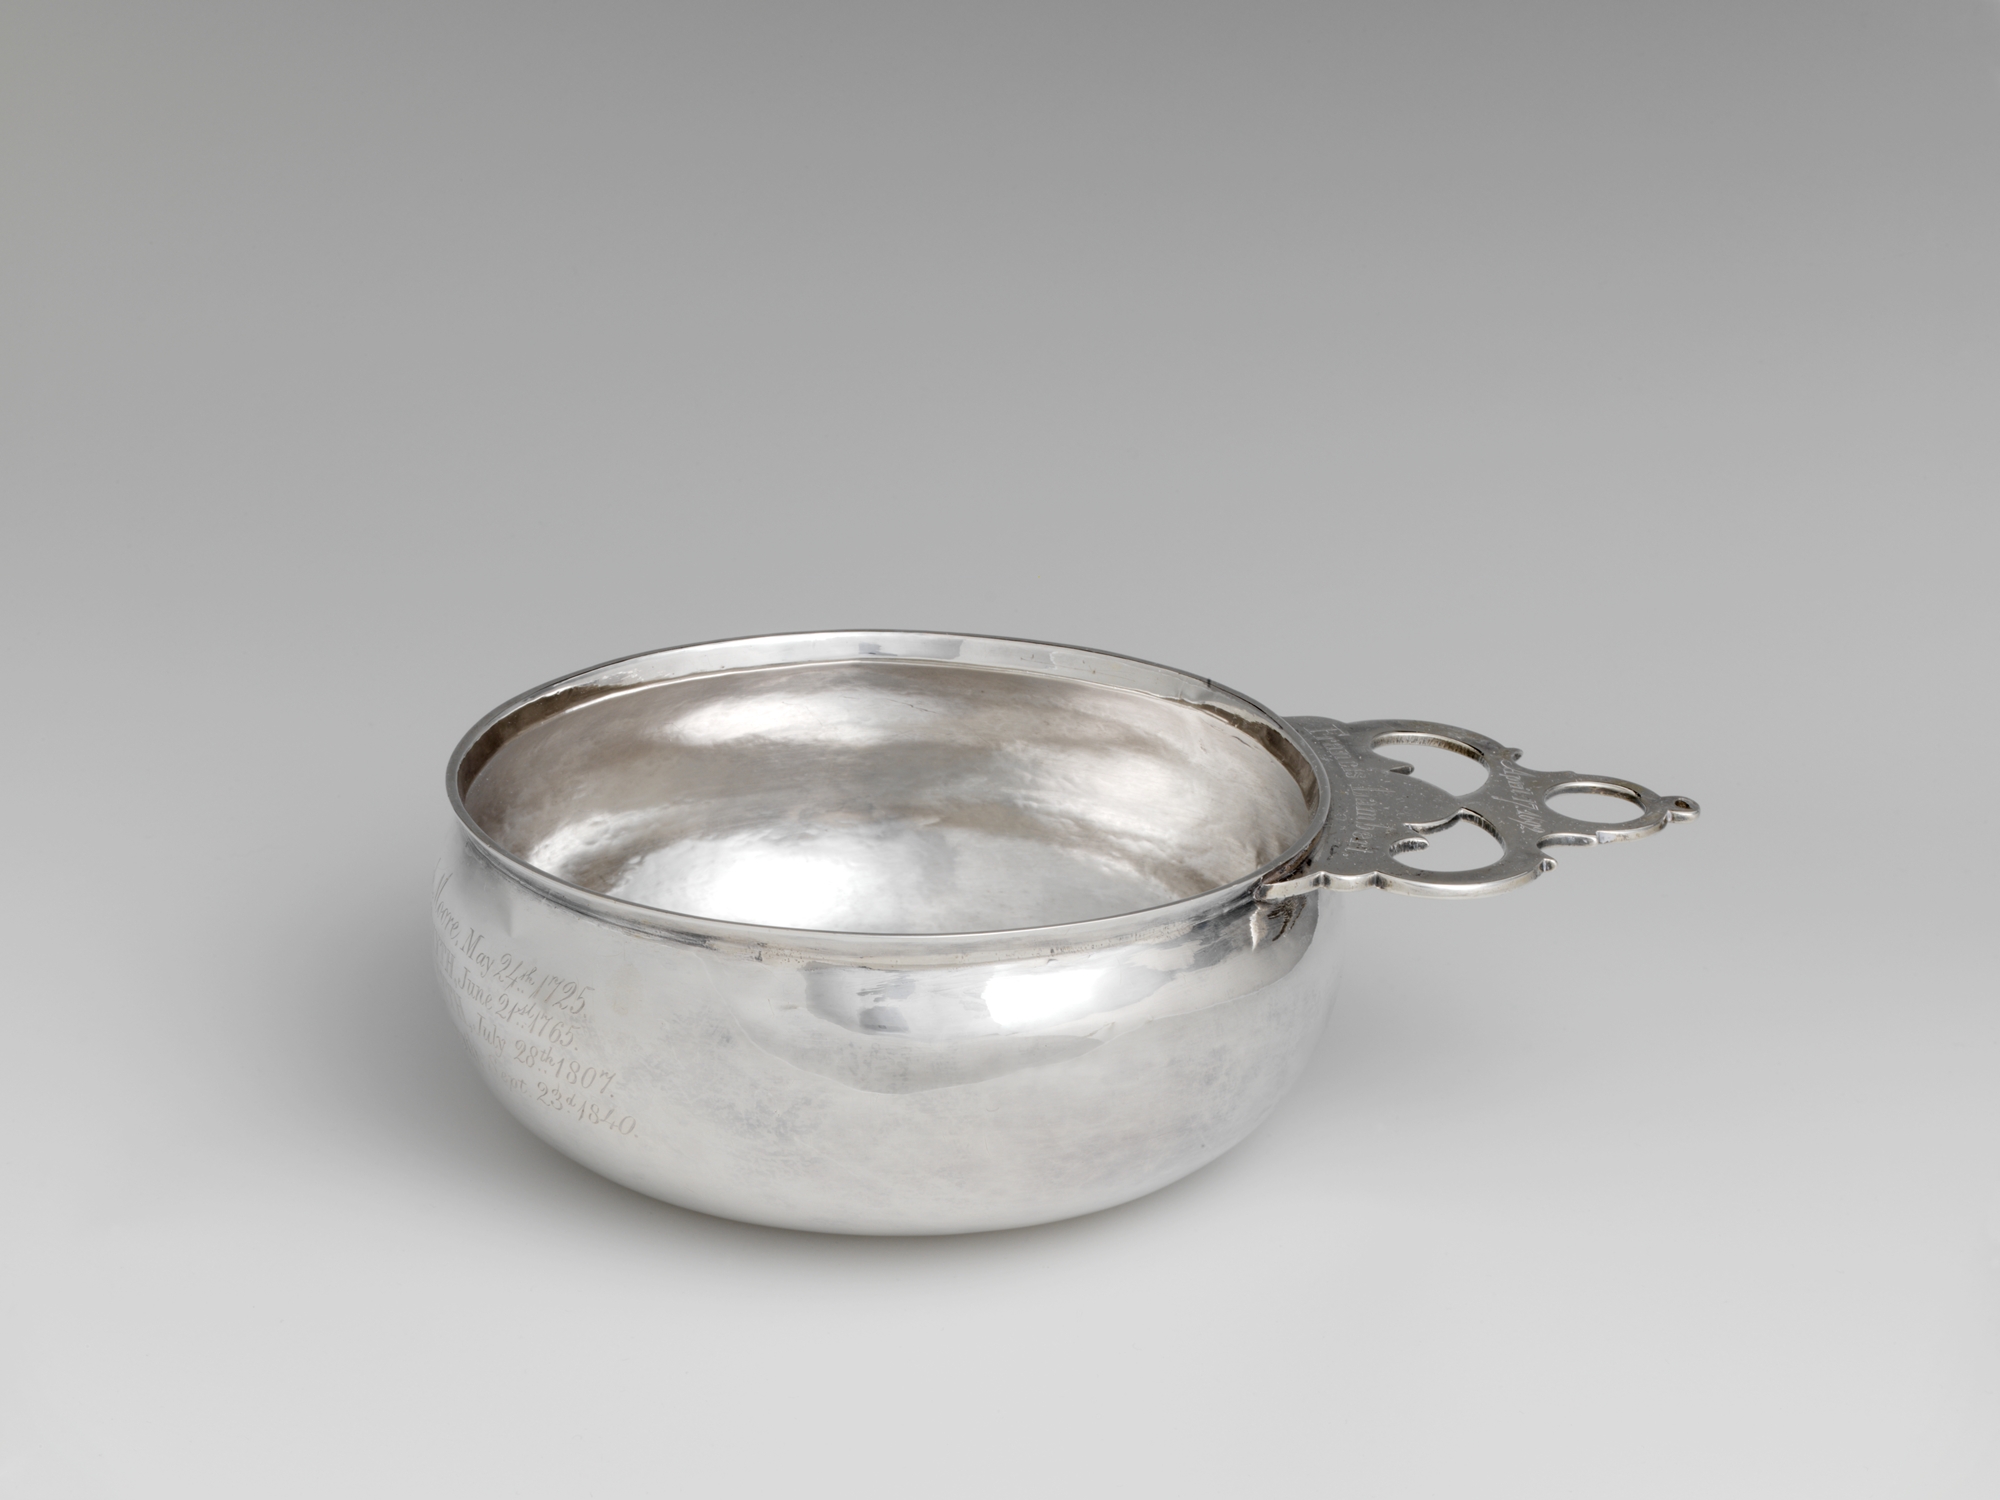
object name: porringer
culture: american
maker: adrian bancker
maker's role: maker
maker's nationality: american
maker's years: 1703-1772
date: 1730-1750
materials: silver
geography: united states